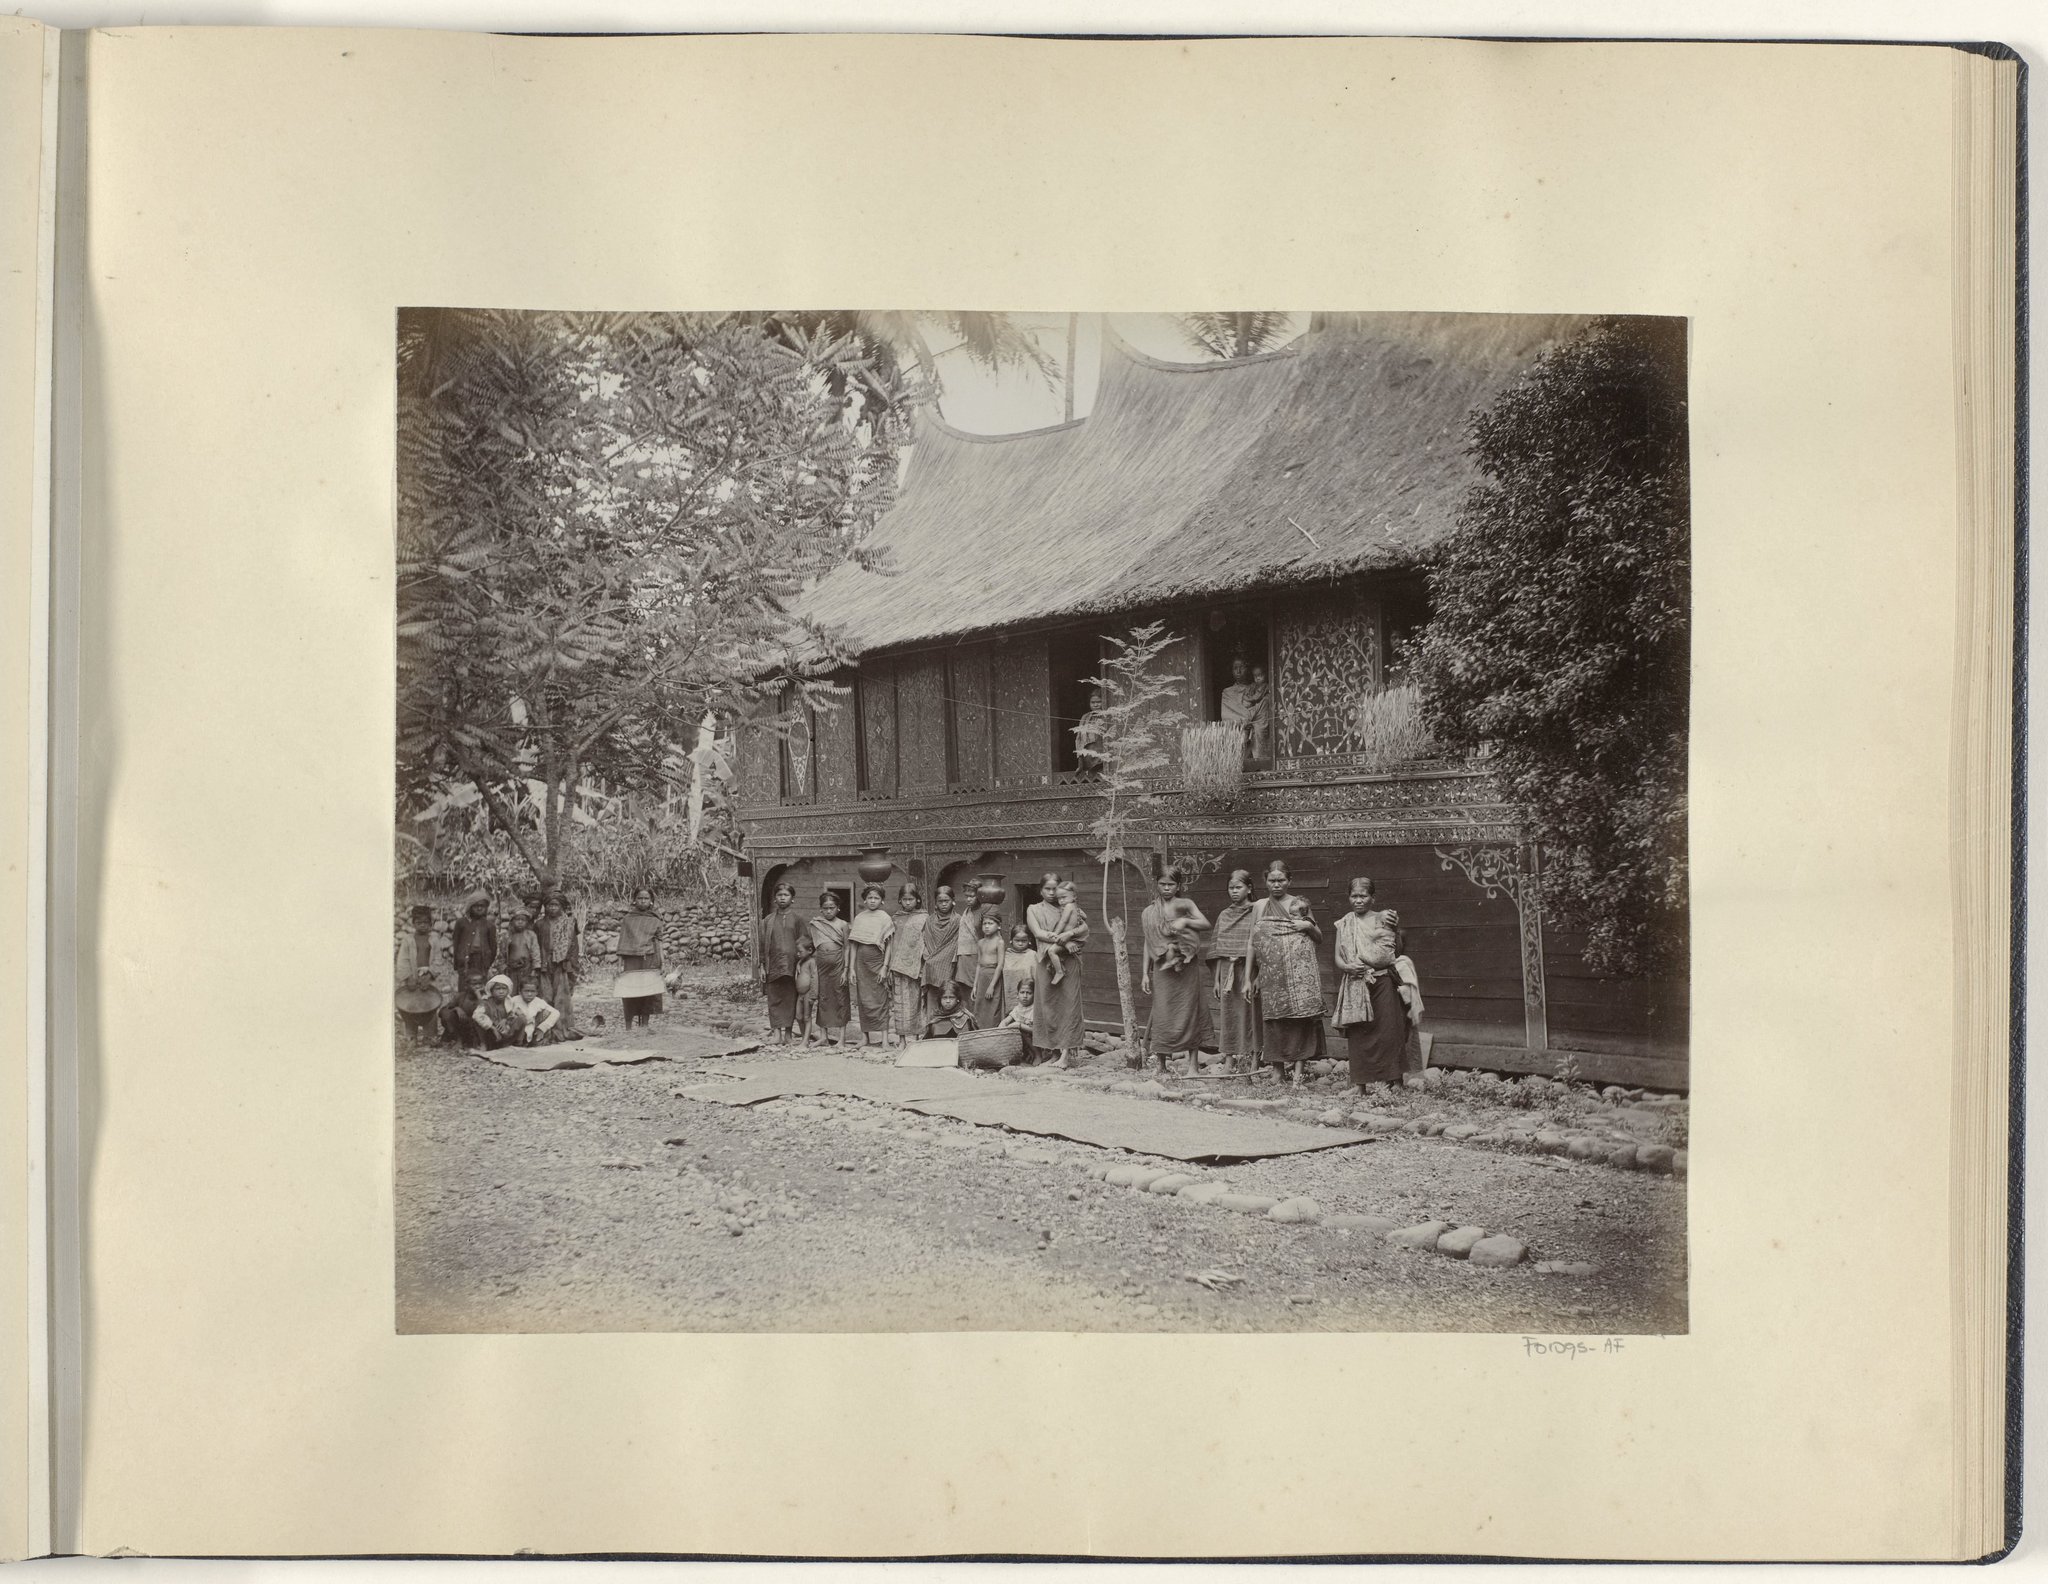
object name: photograph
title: Vrouwen met kinderen voor een huis op Sumatra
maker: Anonymous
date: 1895-1905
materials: paper, photographic support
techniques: albumen print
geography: sumatra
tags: adolescent, young woman, maiden, rural housing, e.g. country-house, villa, cottage, mother and baby or young child, sumatra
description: Onderdeel van Reisalbum met foto's van bezienswaardigheden in Italië, Zwitserland en Nederlands-Indië.